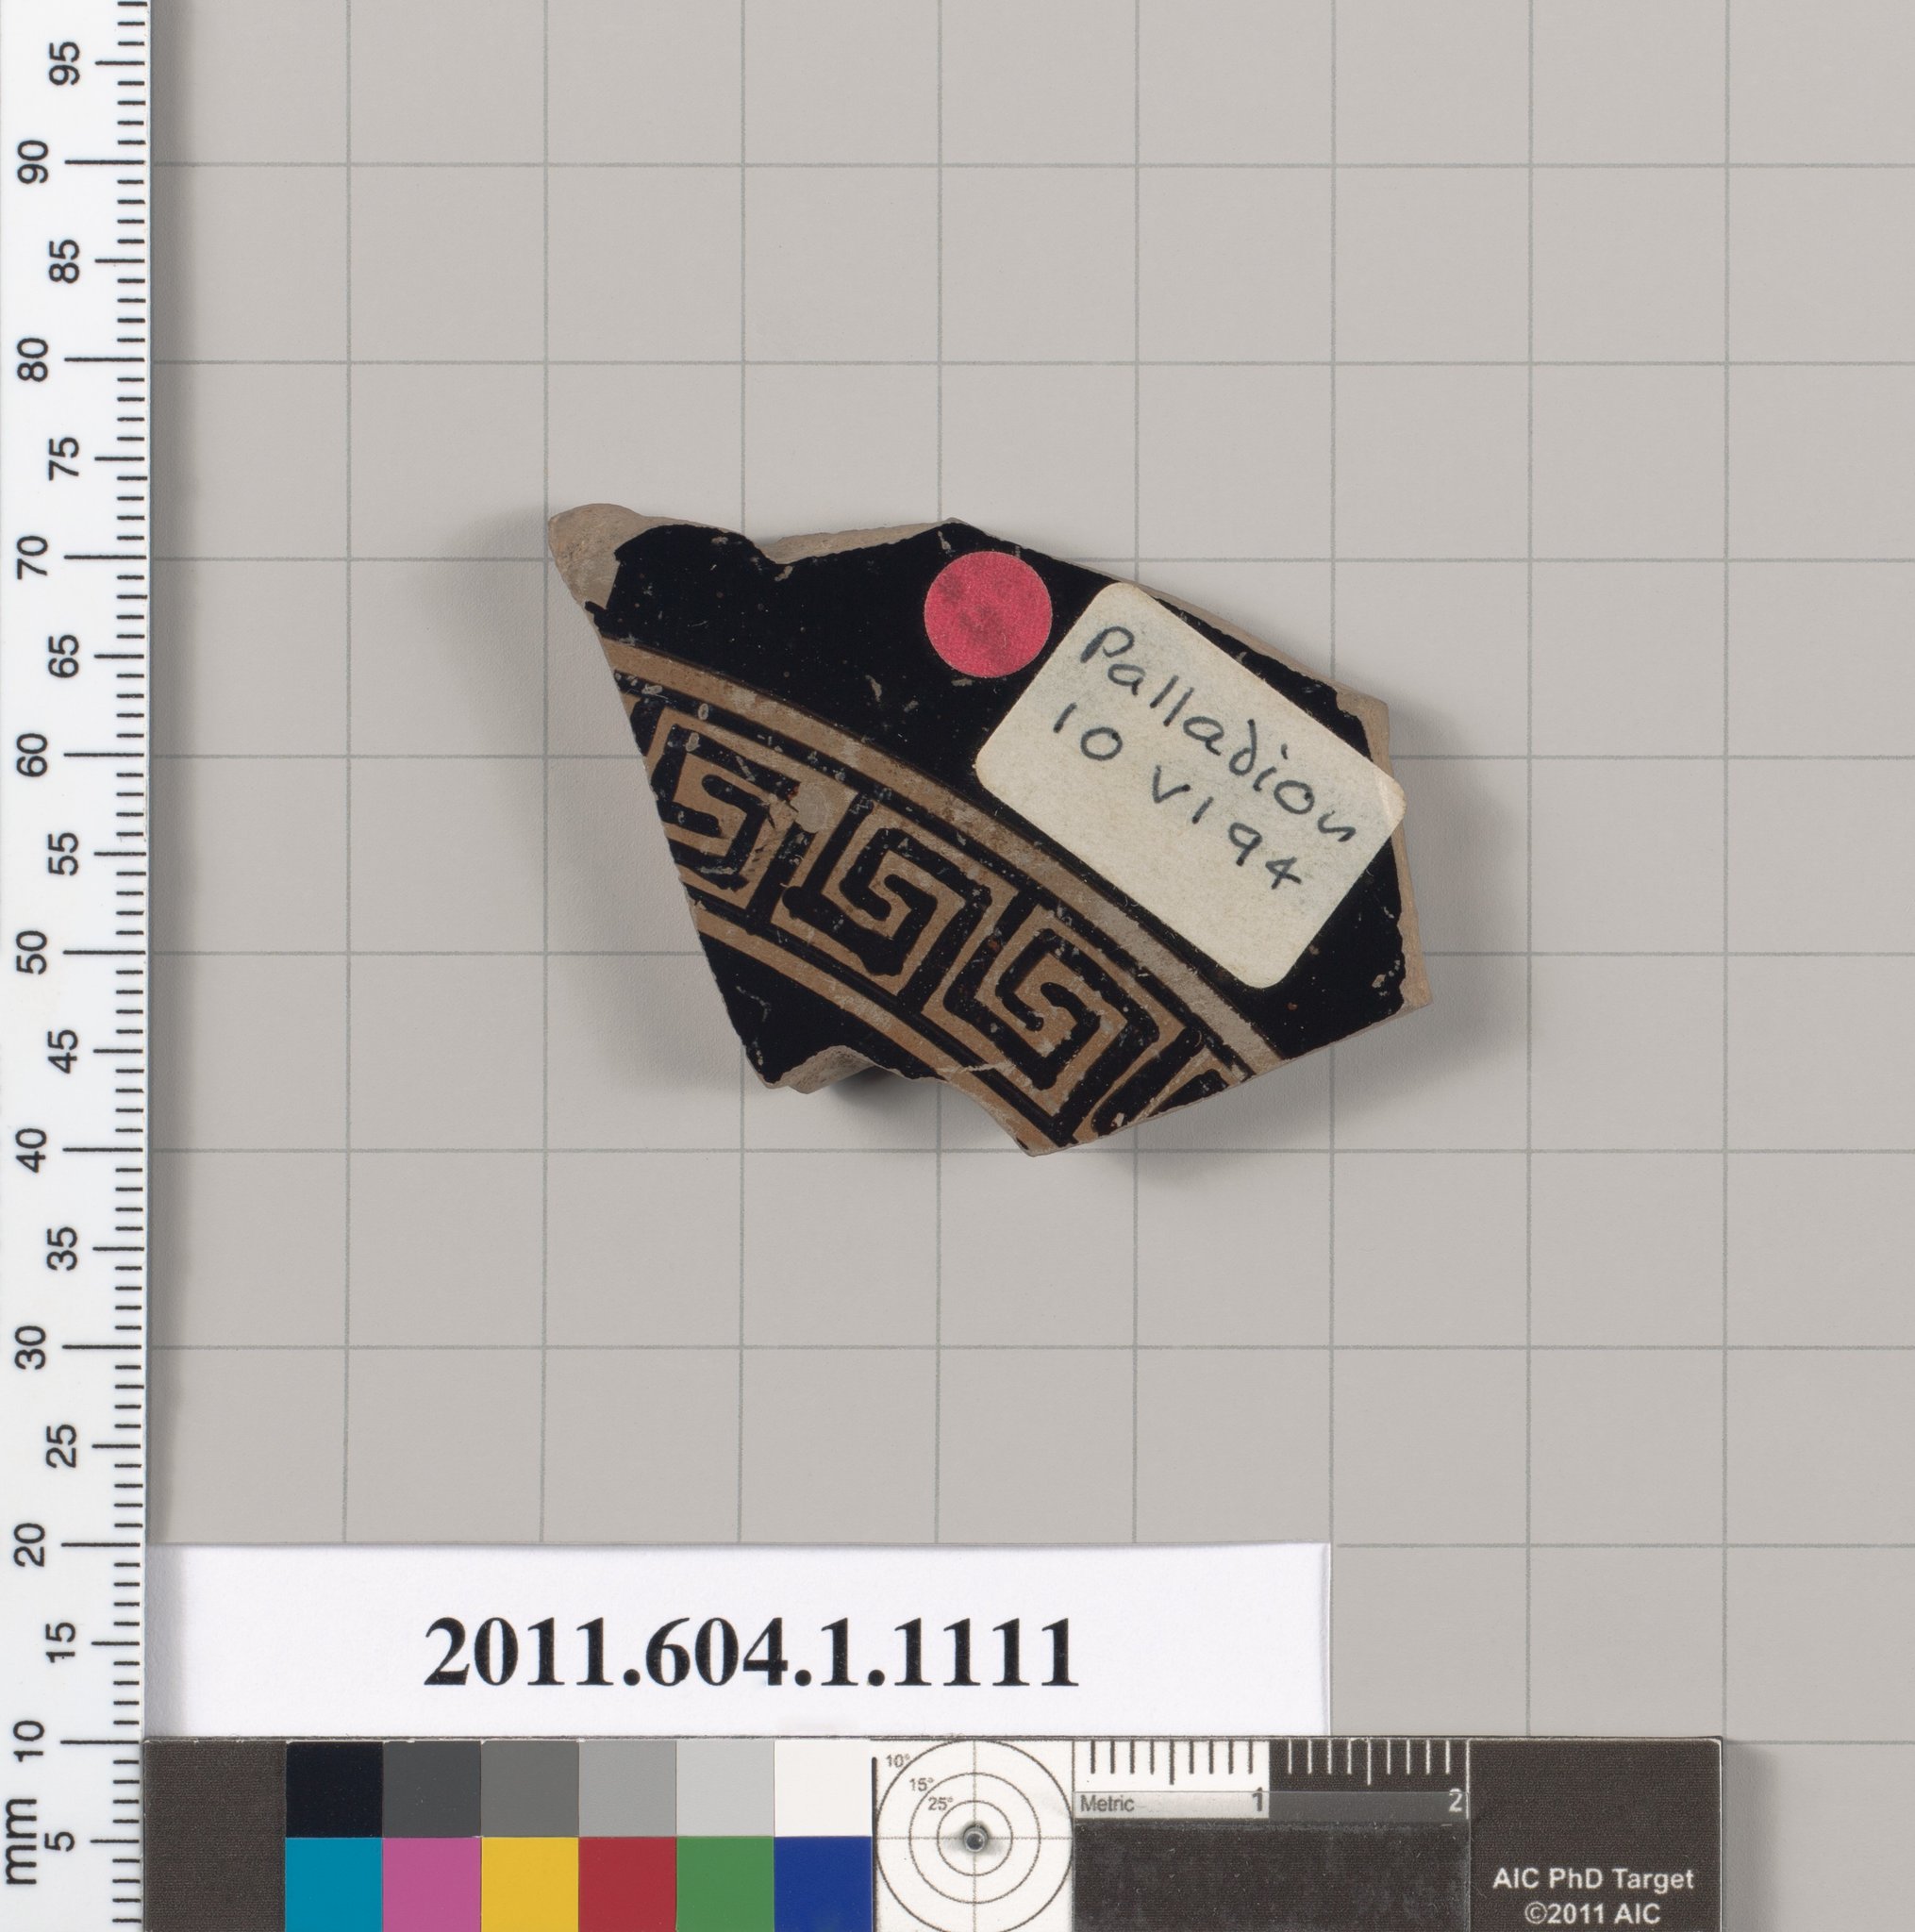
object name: kylix fragment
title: Terracotta fragment of a kylix (drinking cup)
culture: greek, attic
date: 490-480 BCE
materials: terracotta